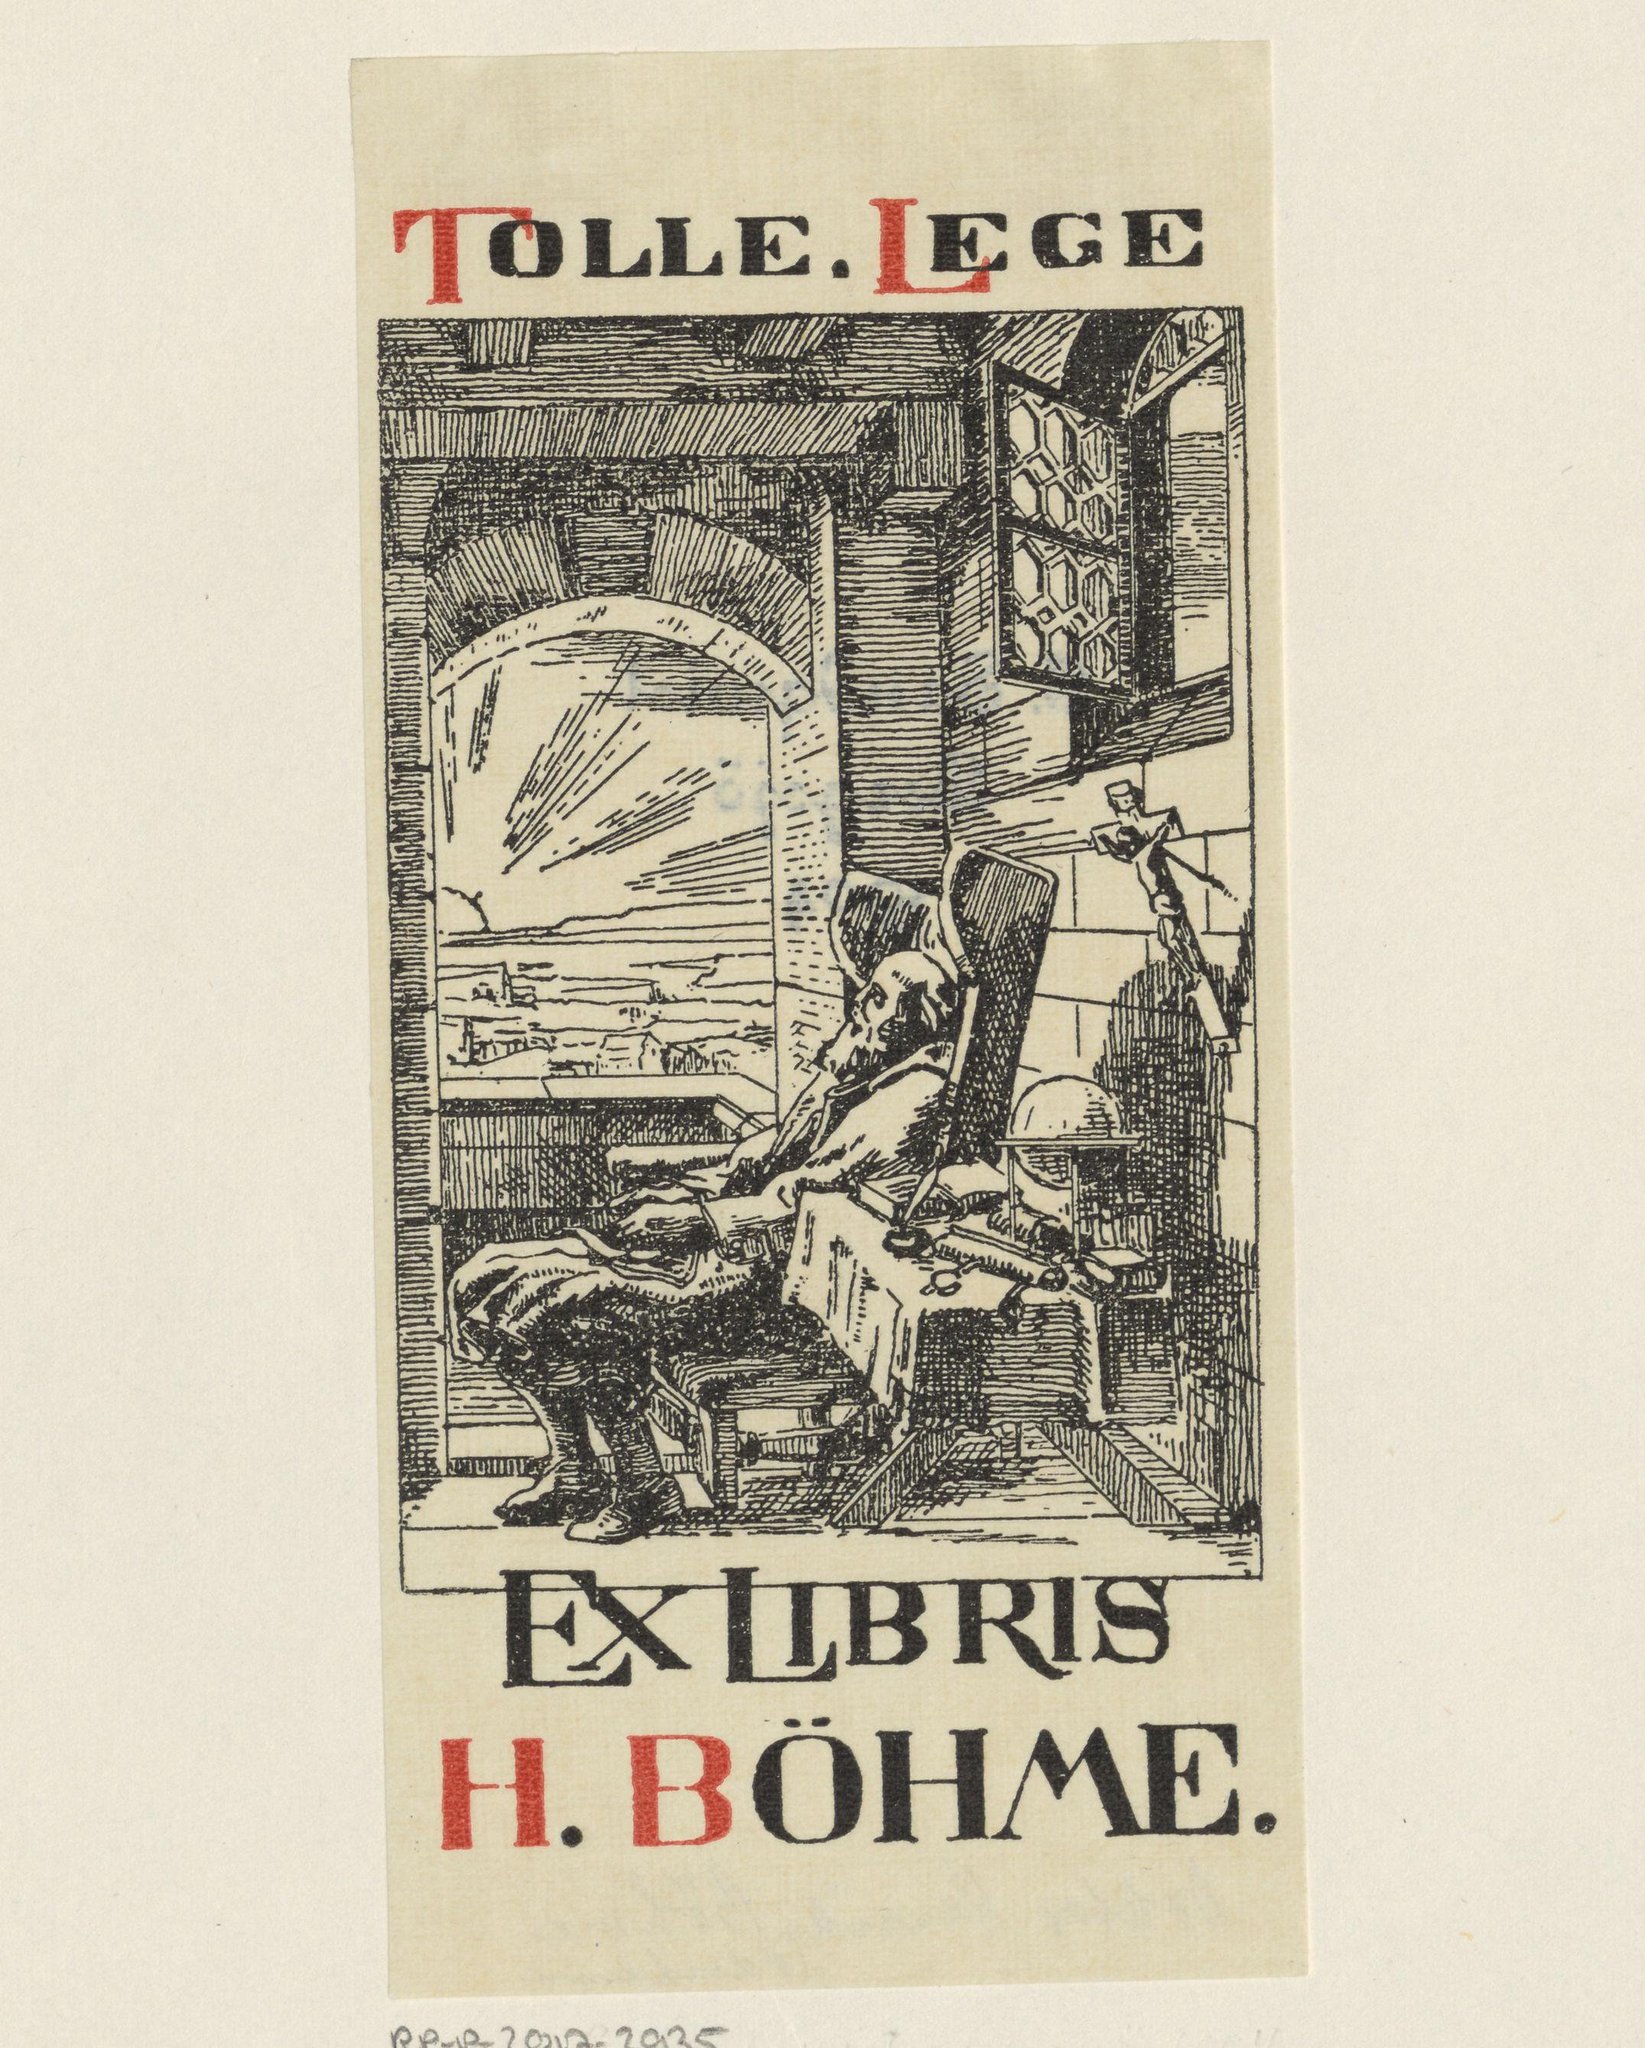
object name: bookplate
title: Ex libris van H. Böhme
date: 1904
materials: paper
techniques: printing block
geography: sweden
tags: sitting figure, view through a window, old man, crucifix ~ personal devotion, sunset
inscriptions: workshop stamp: ‘G. Sandqvist / Bergsjö / 1904’